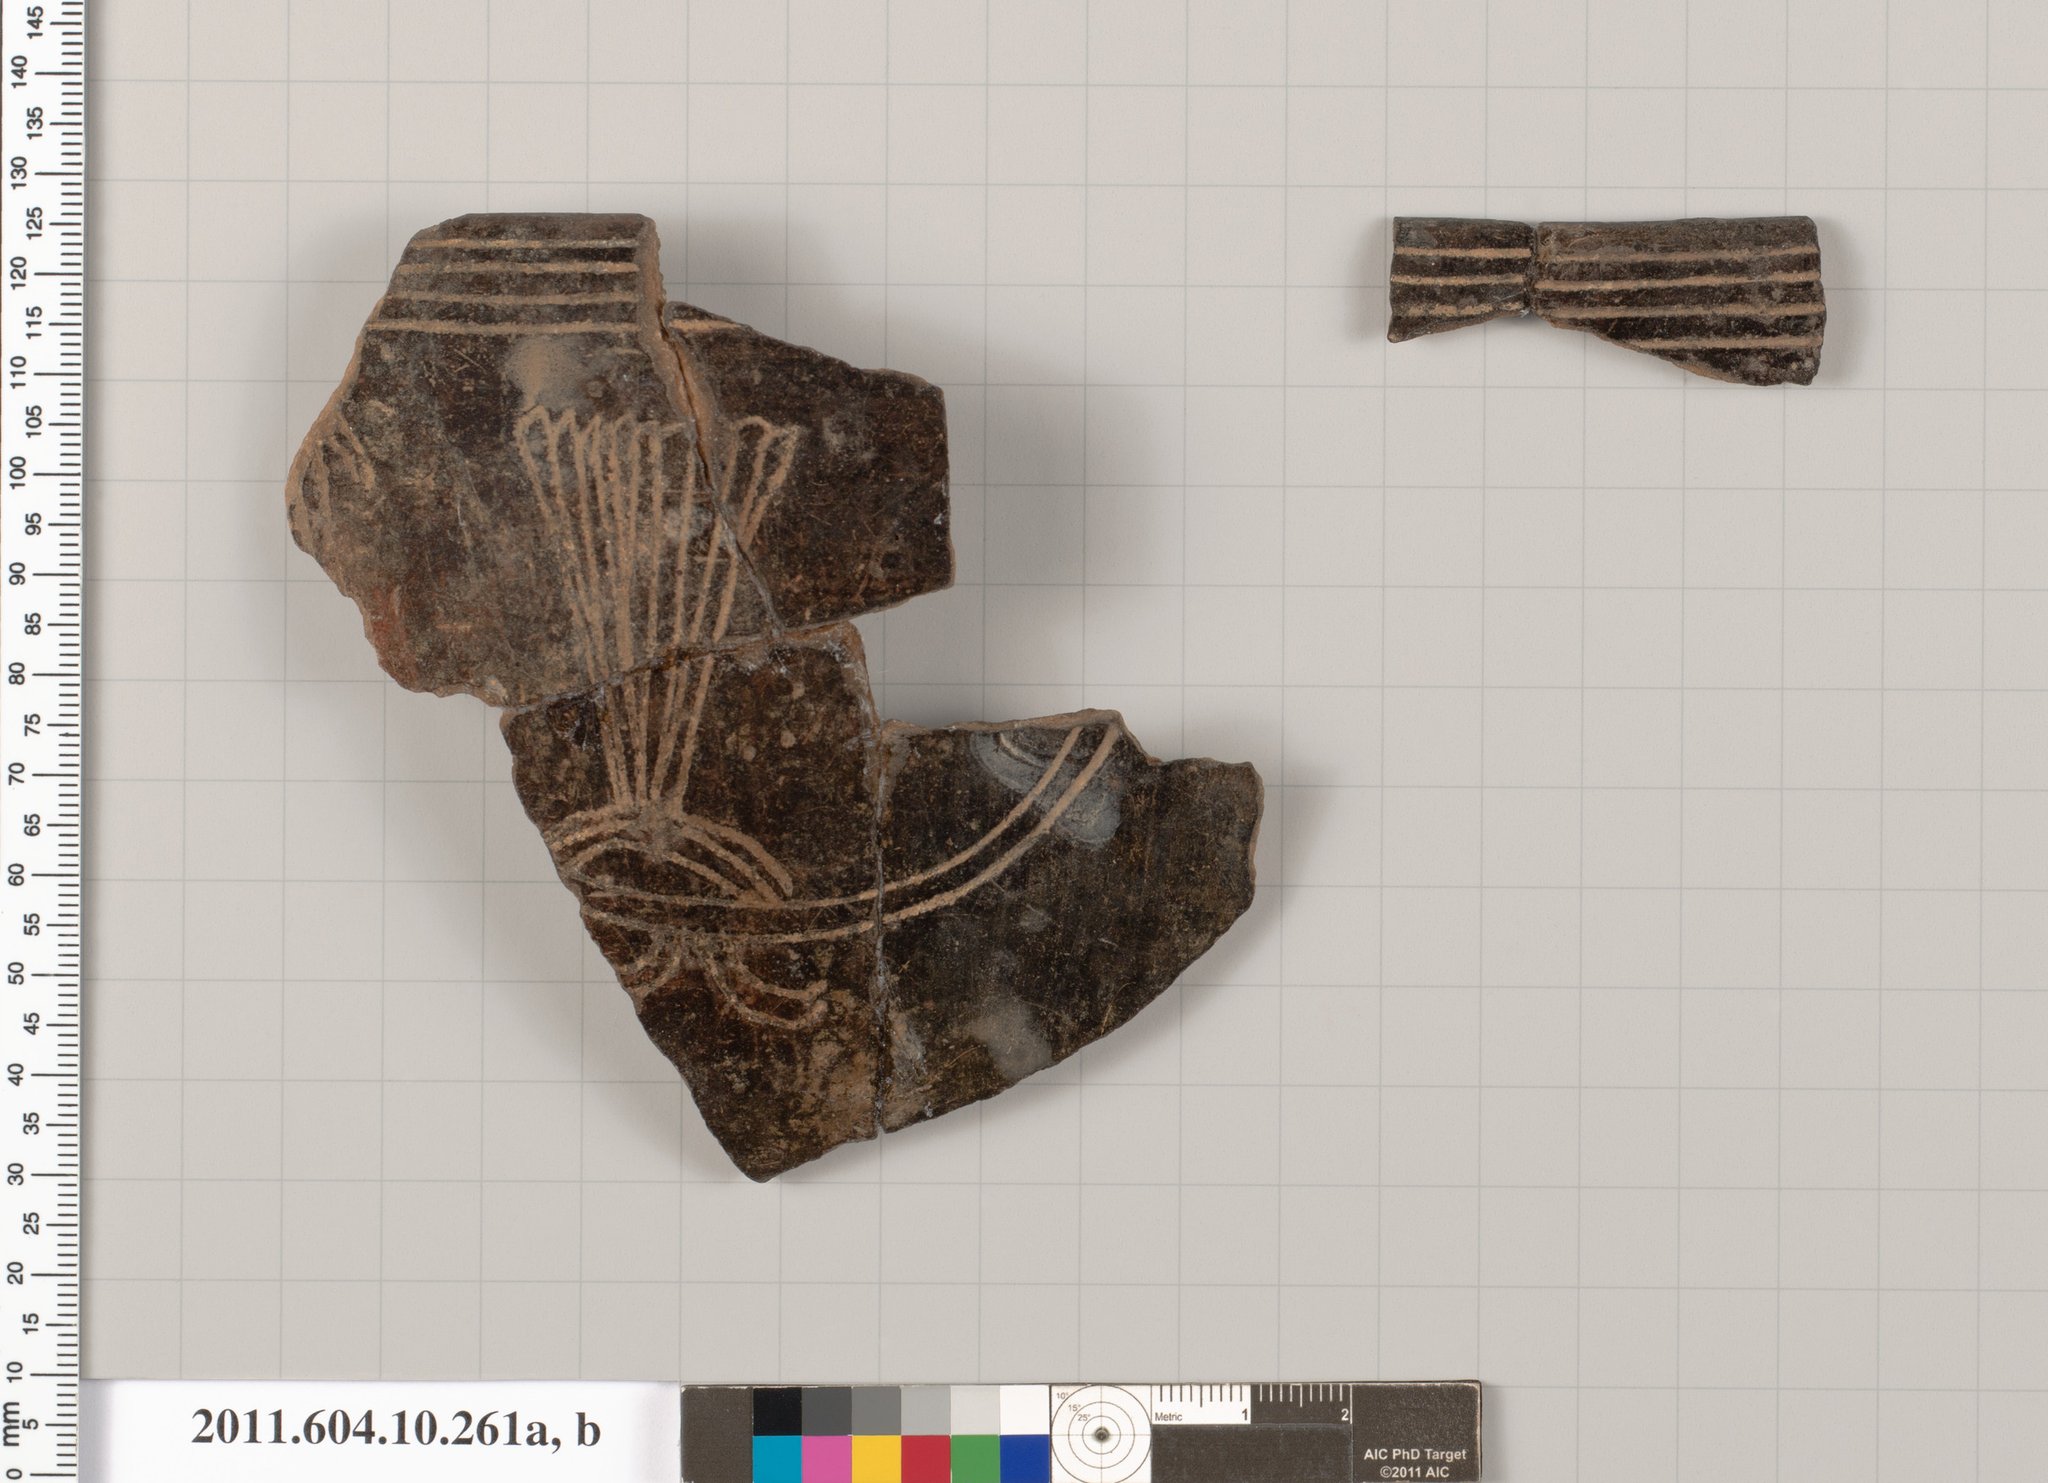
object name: kantharos fragment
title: Terracotta fragments of a kantharos (drinking cup with high handles)?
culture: etruscan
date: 650-600 BCE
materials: terracotta